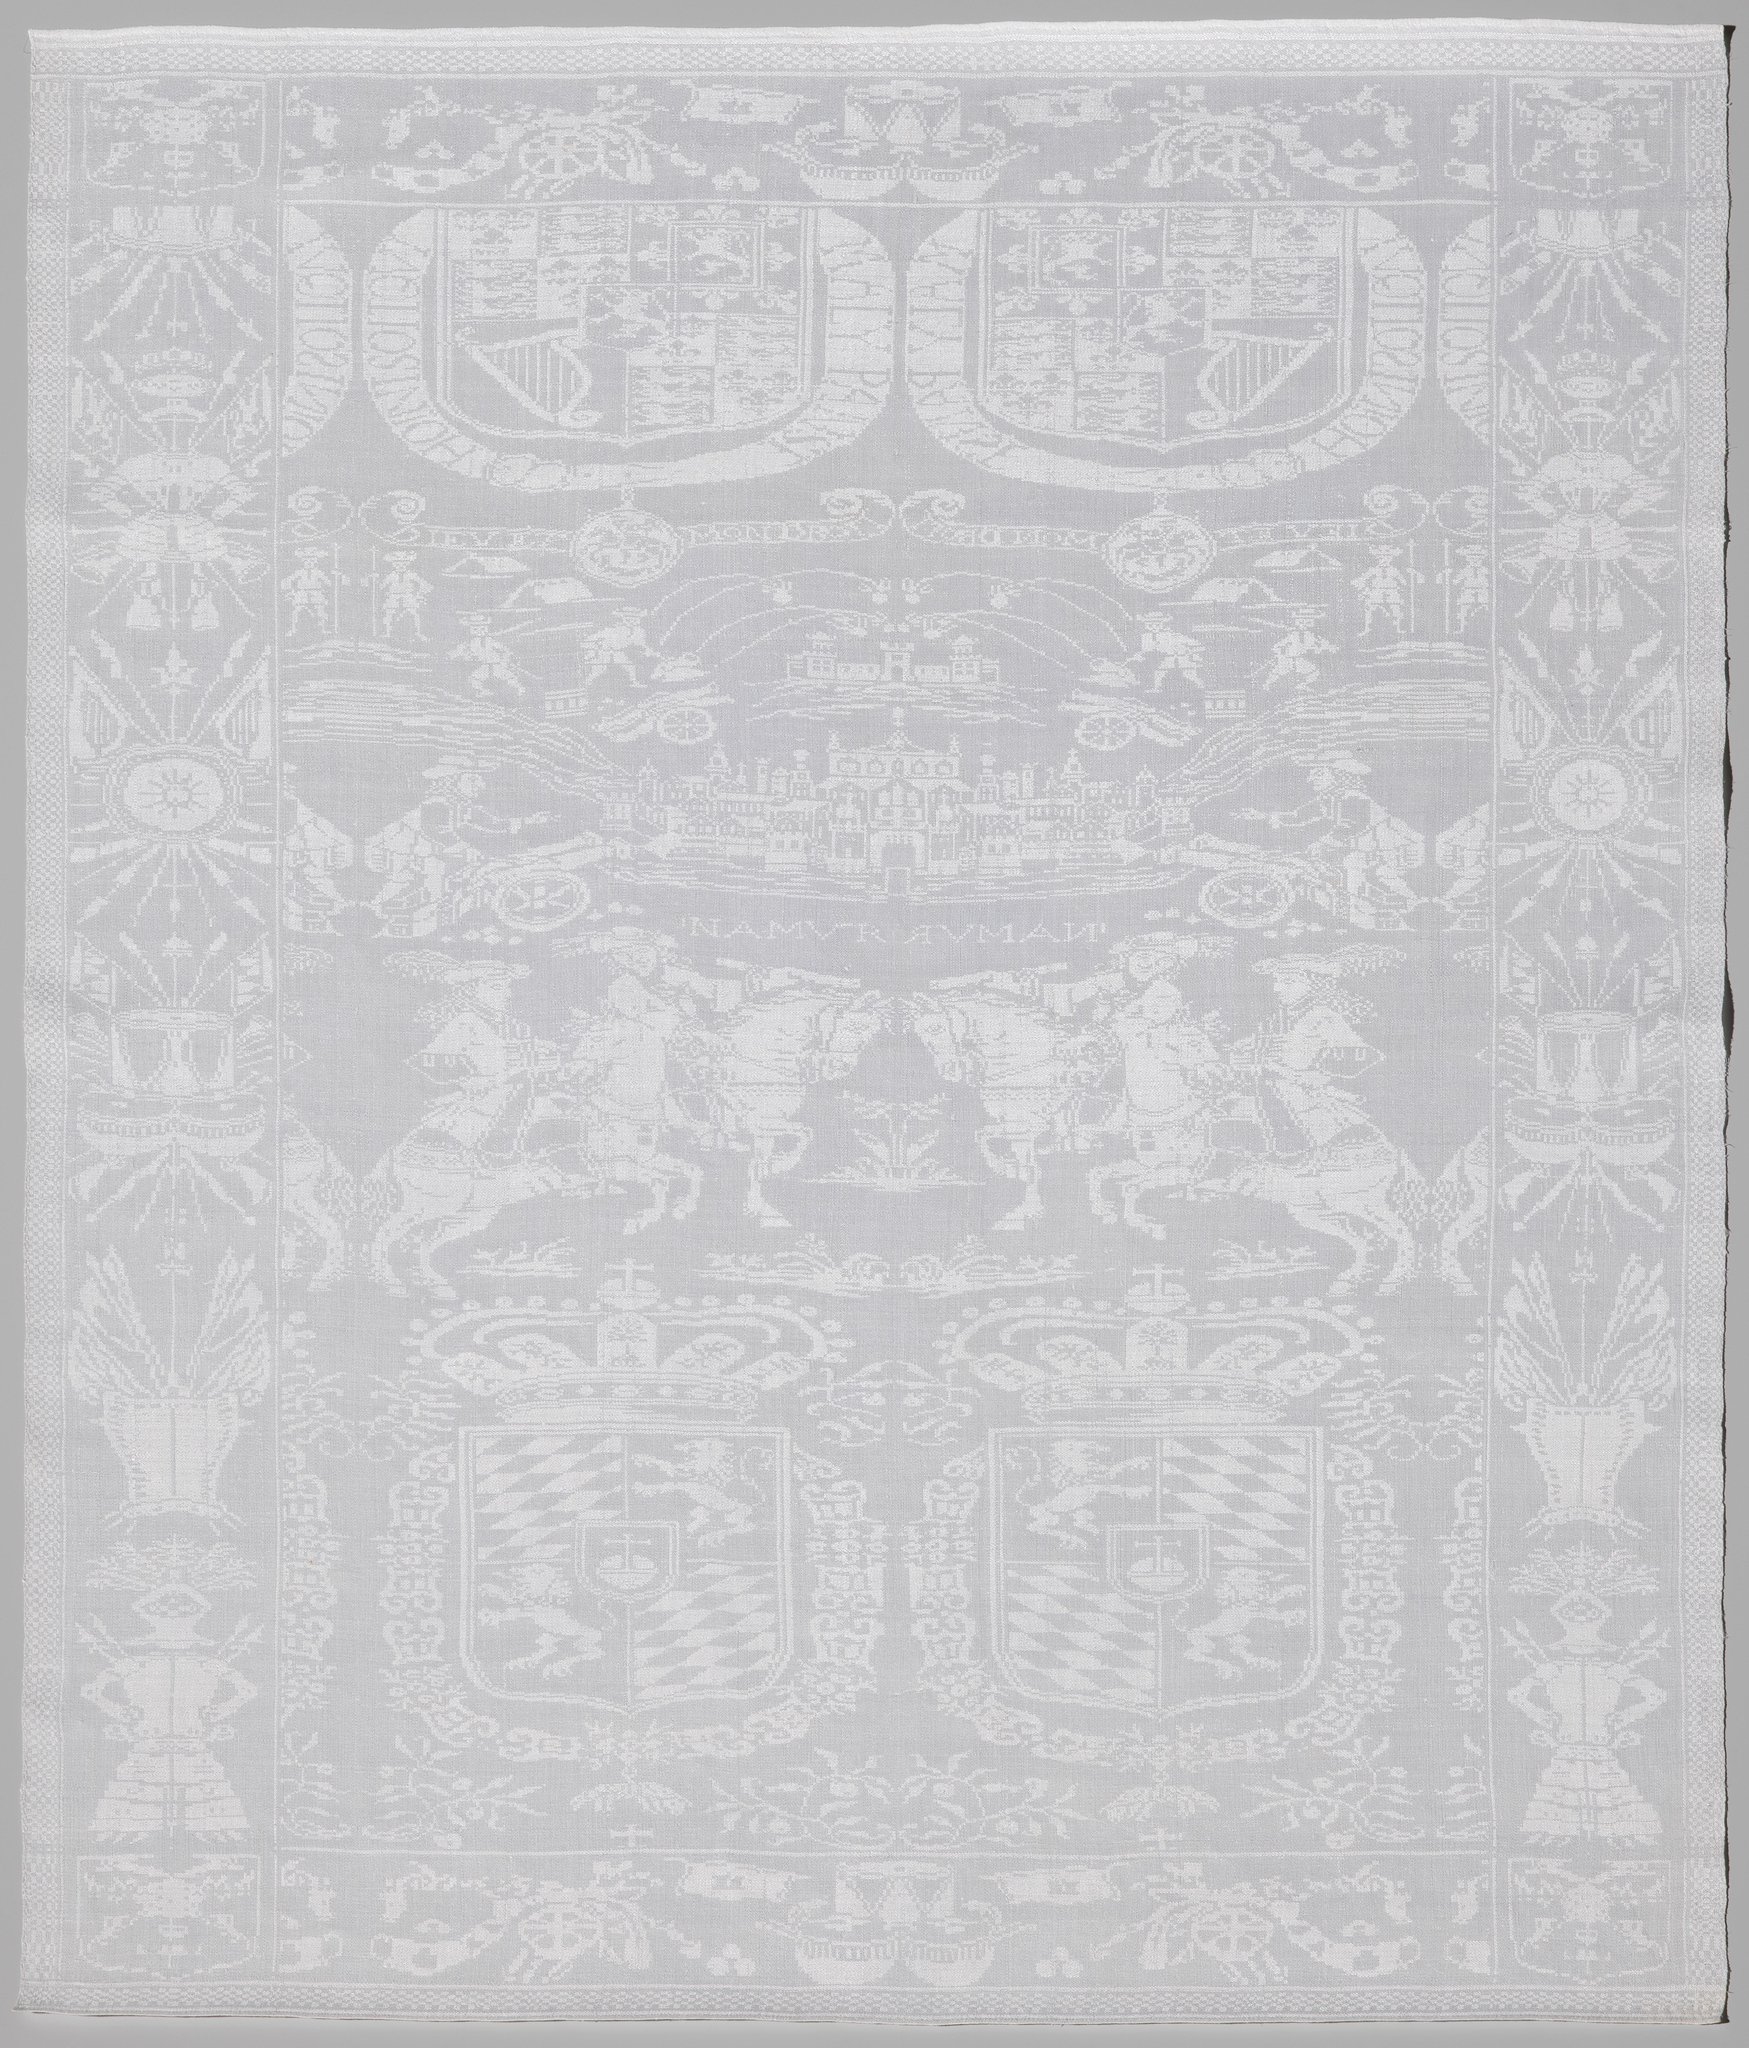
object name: napkin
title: Servet met verovering Namen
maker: Anonymous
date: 1695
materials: linen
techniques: damask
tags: the hague, william iii (prince of orange and king of england, scotland, and ireland), maximiliaan ii emanuel (keurvorst van beieren)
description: Servet van wit linnendamast met gekroonde wapens van Stadhouder-Koning Willem III en Maximiliaan van Beieren, respectievelijk omhangen met het lint van de Orde van de Kouseband en de keten van de Orde van het Gulden Vlies; voorts een gezicht op de belegerde stad NAMVR aan de rivier, met het hoog op de berg gelegen fort, en de ruiterfiguren van de beide veldheren.